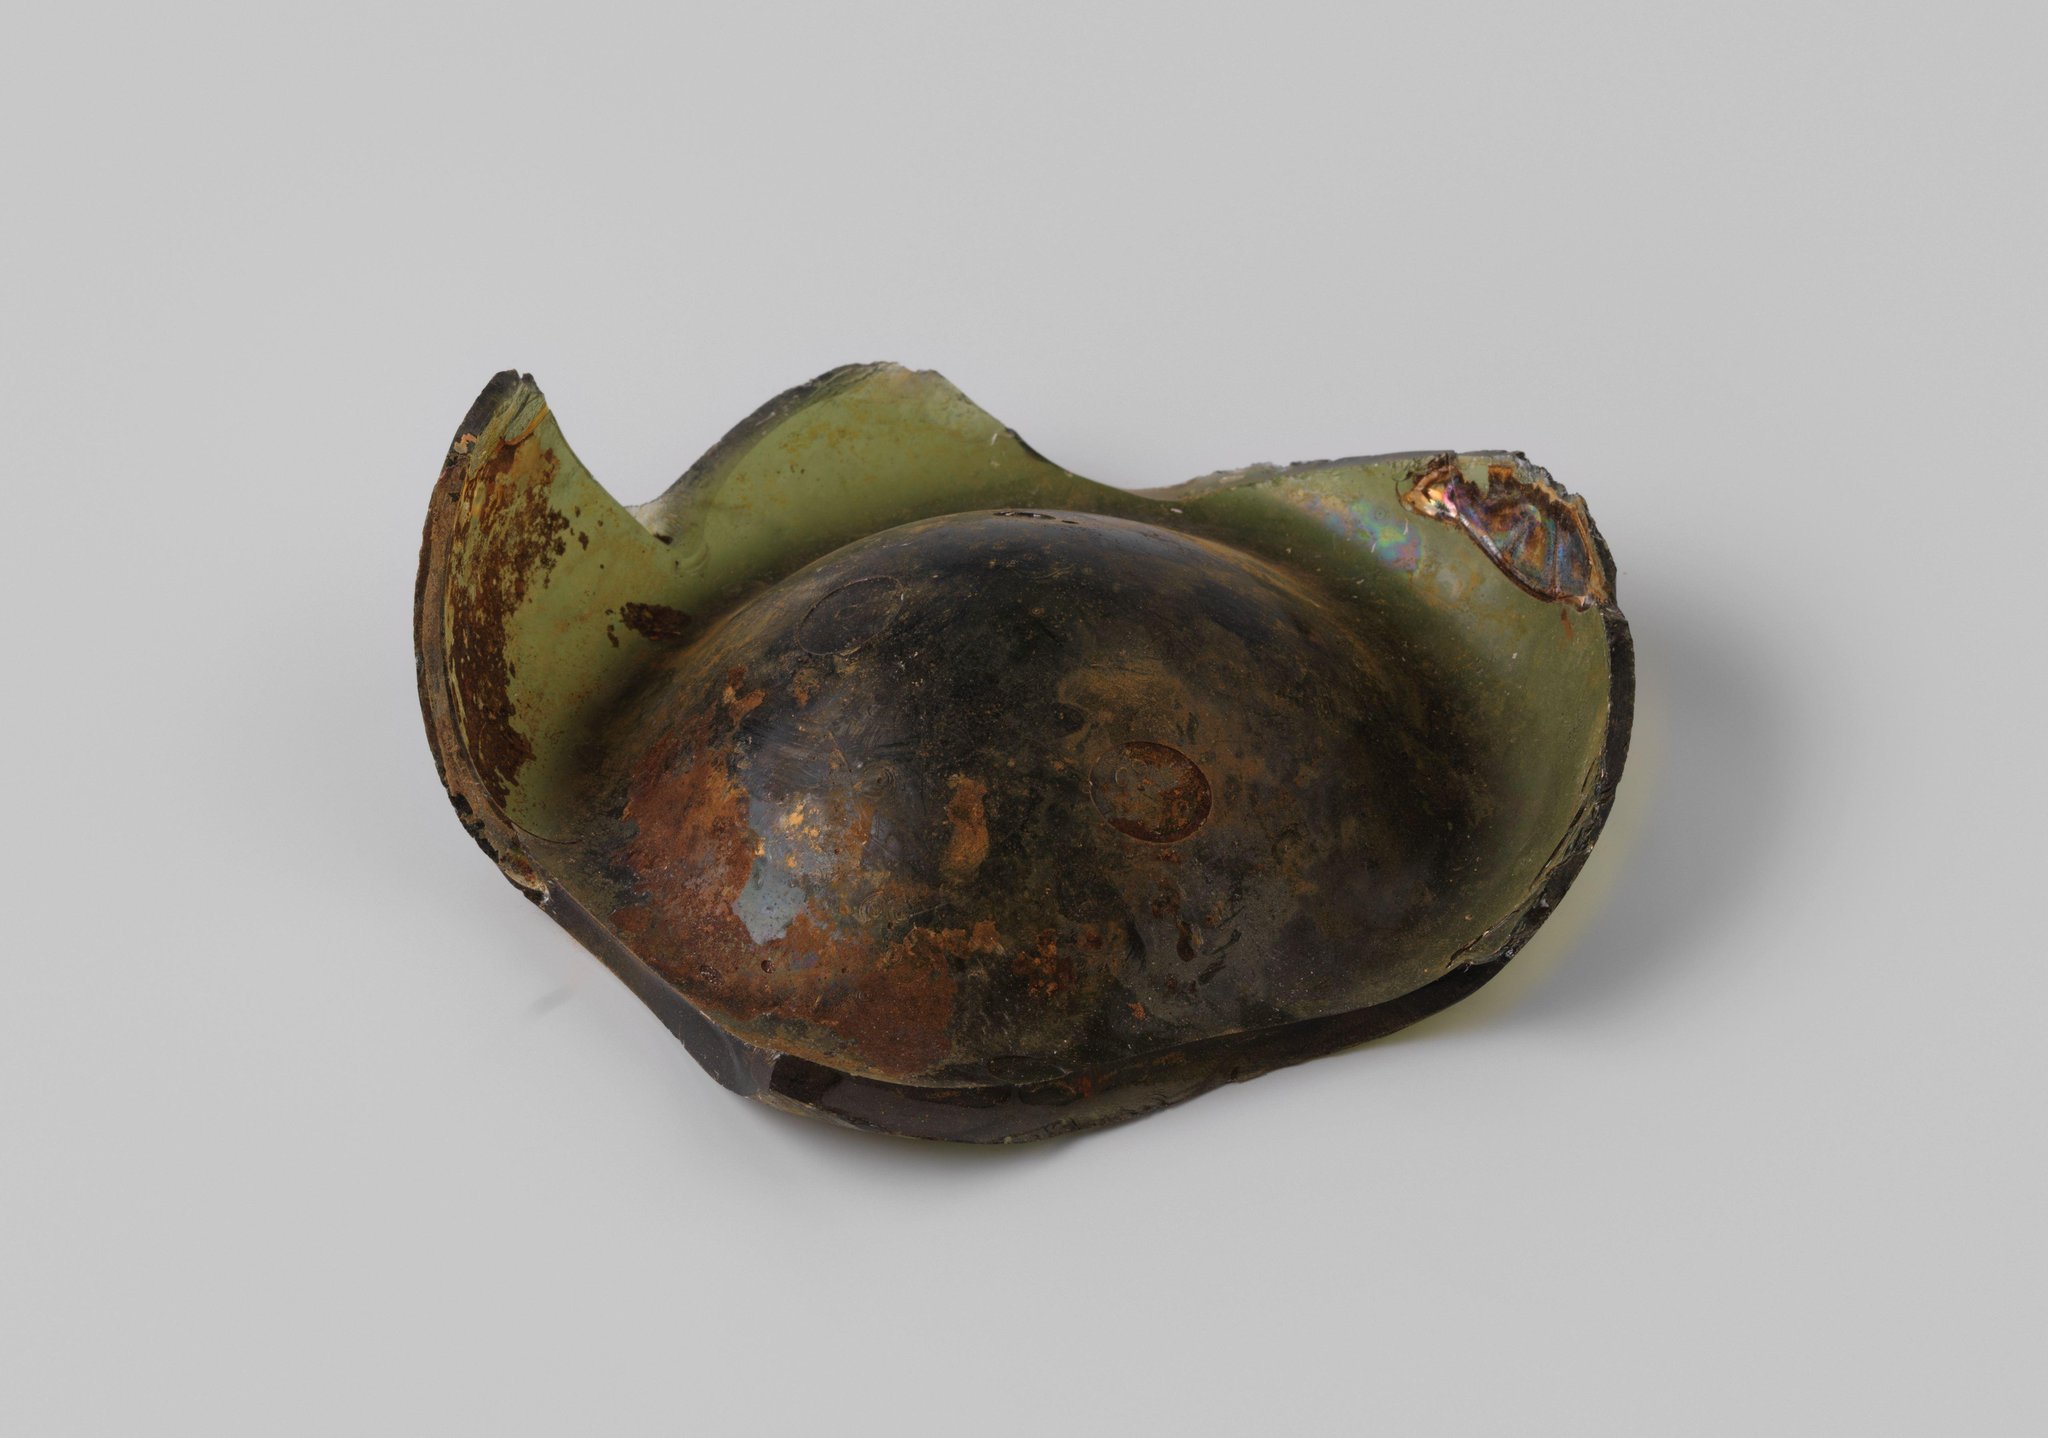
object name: wine bottle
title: Bodemfragment wijnfles uit het wrak van de Oost-Indiëvaarder Hollandia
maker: Anonymous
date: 1700-1743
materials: glass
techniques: green glass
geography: netherlands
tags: verenigde oostindische compagnie, hollandia (schip), annet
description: Onion-shaped bottle or bottle with vertical side, base, cs-kick-up. Continental production.